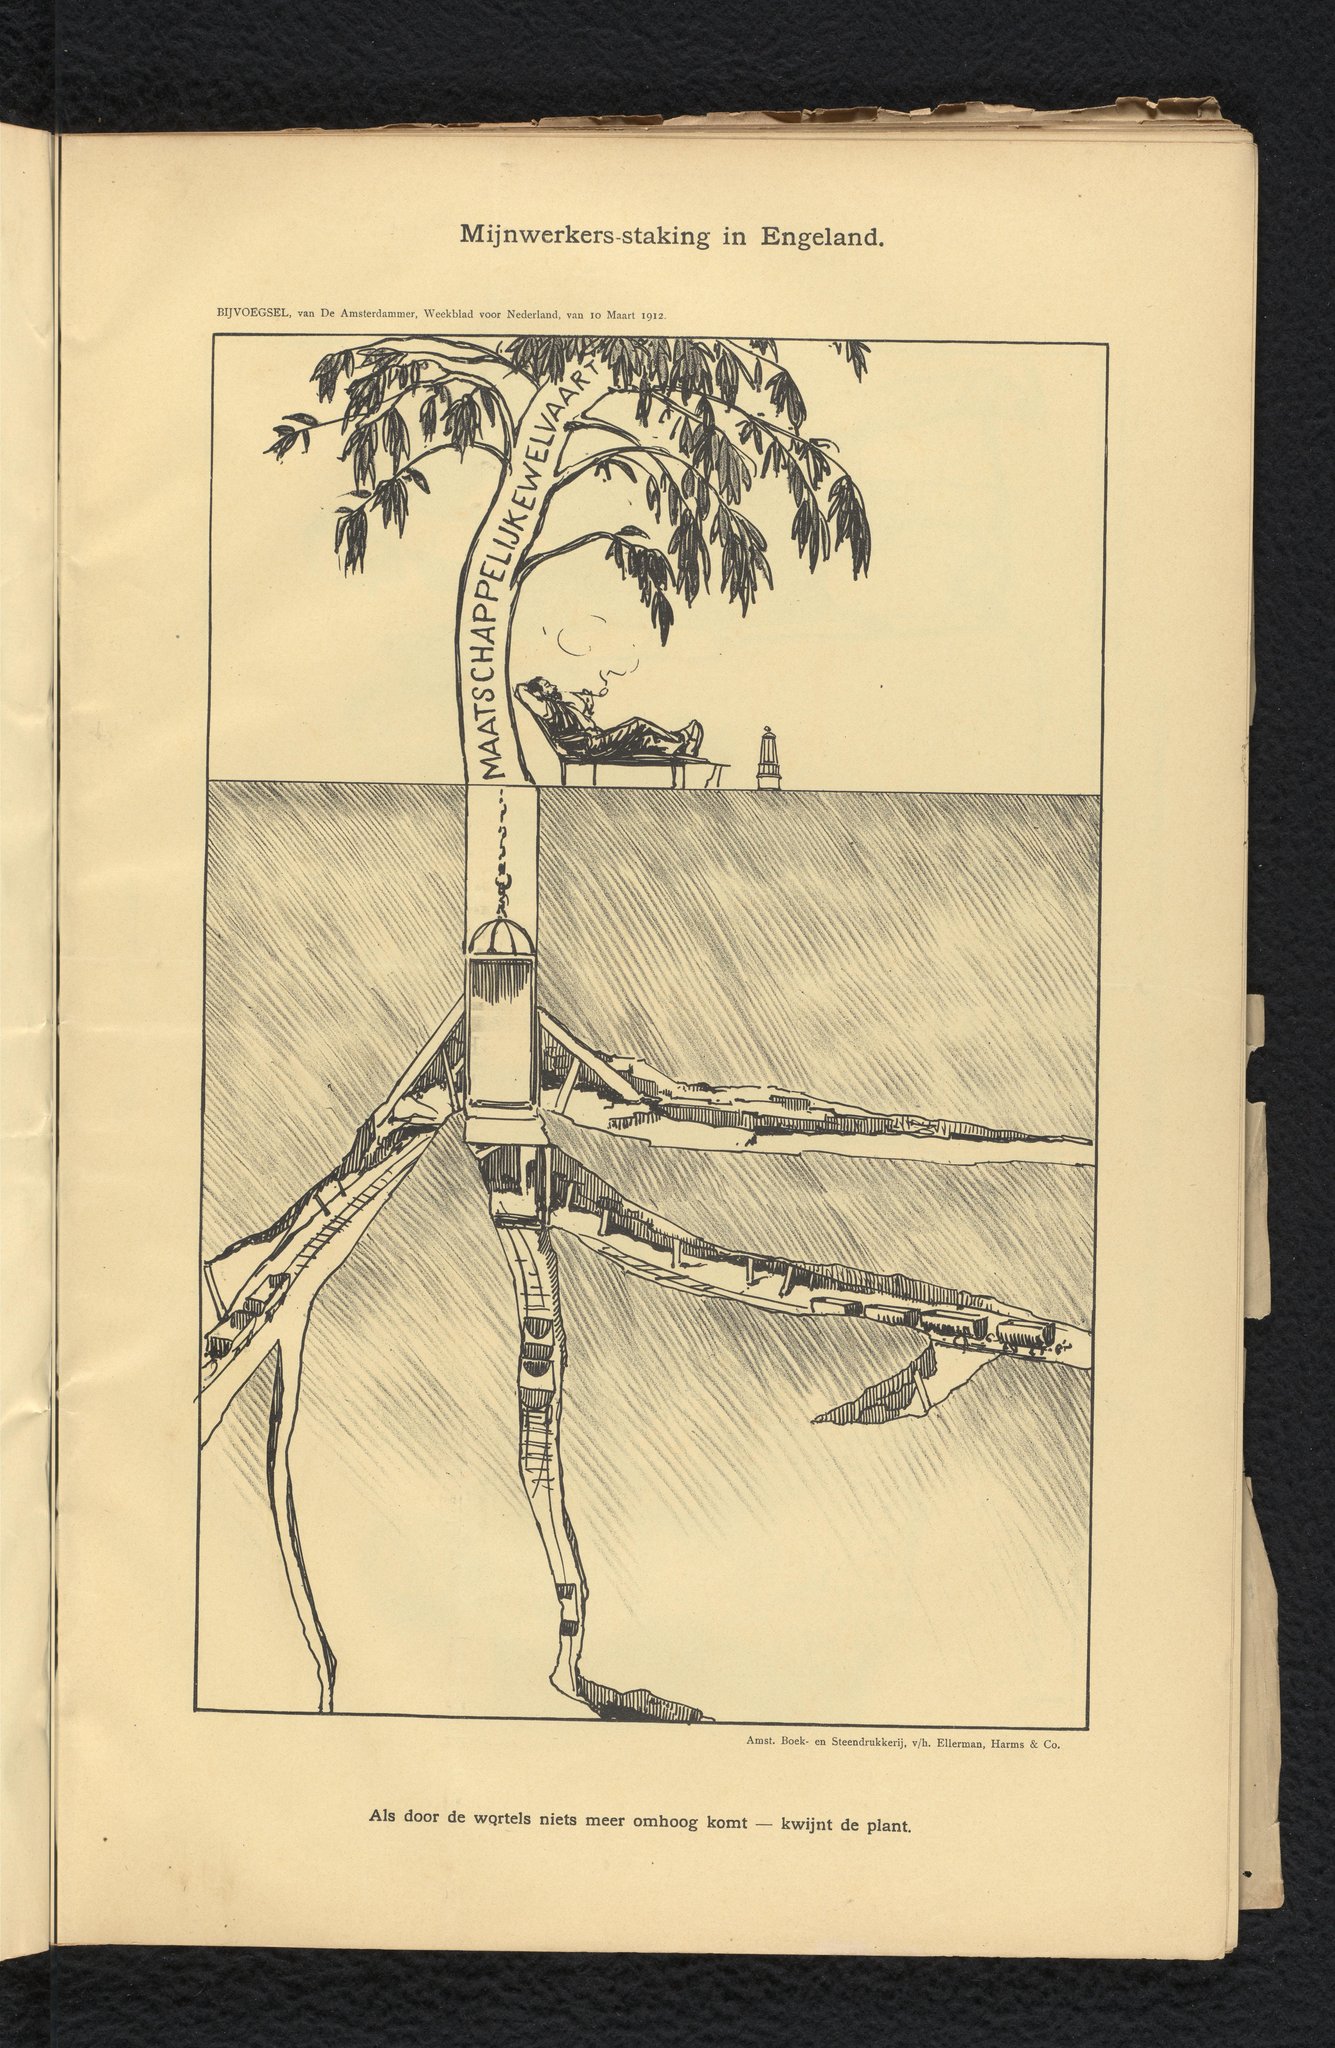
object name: cartoon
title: Mijnwerkers-staking in Engeland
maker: johan braakensiek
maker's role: draughtsman, print maker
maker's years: 1858-1940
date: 1912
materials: paper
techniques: lithograph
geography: netherlands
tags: shafts and galleries (of a mine), political caricatures and satires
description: Gepubliceerd als bijvoegsel bij 'De Amsterdammer' van 10 maart 1912.